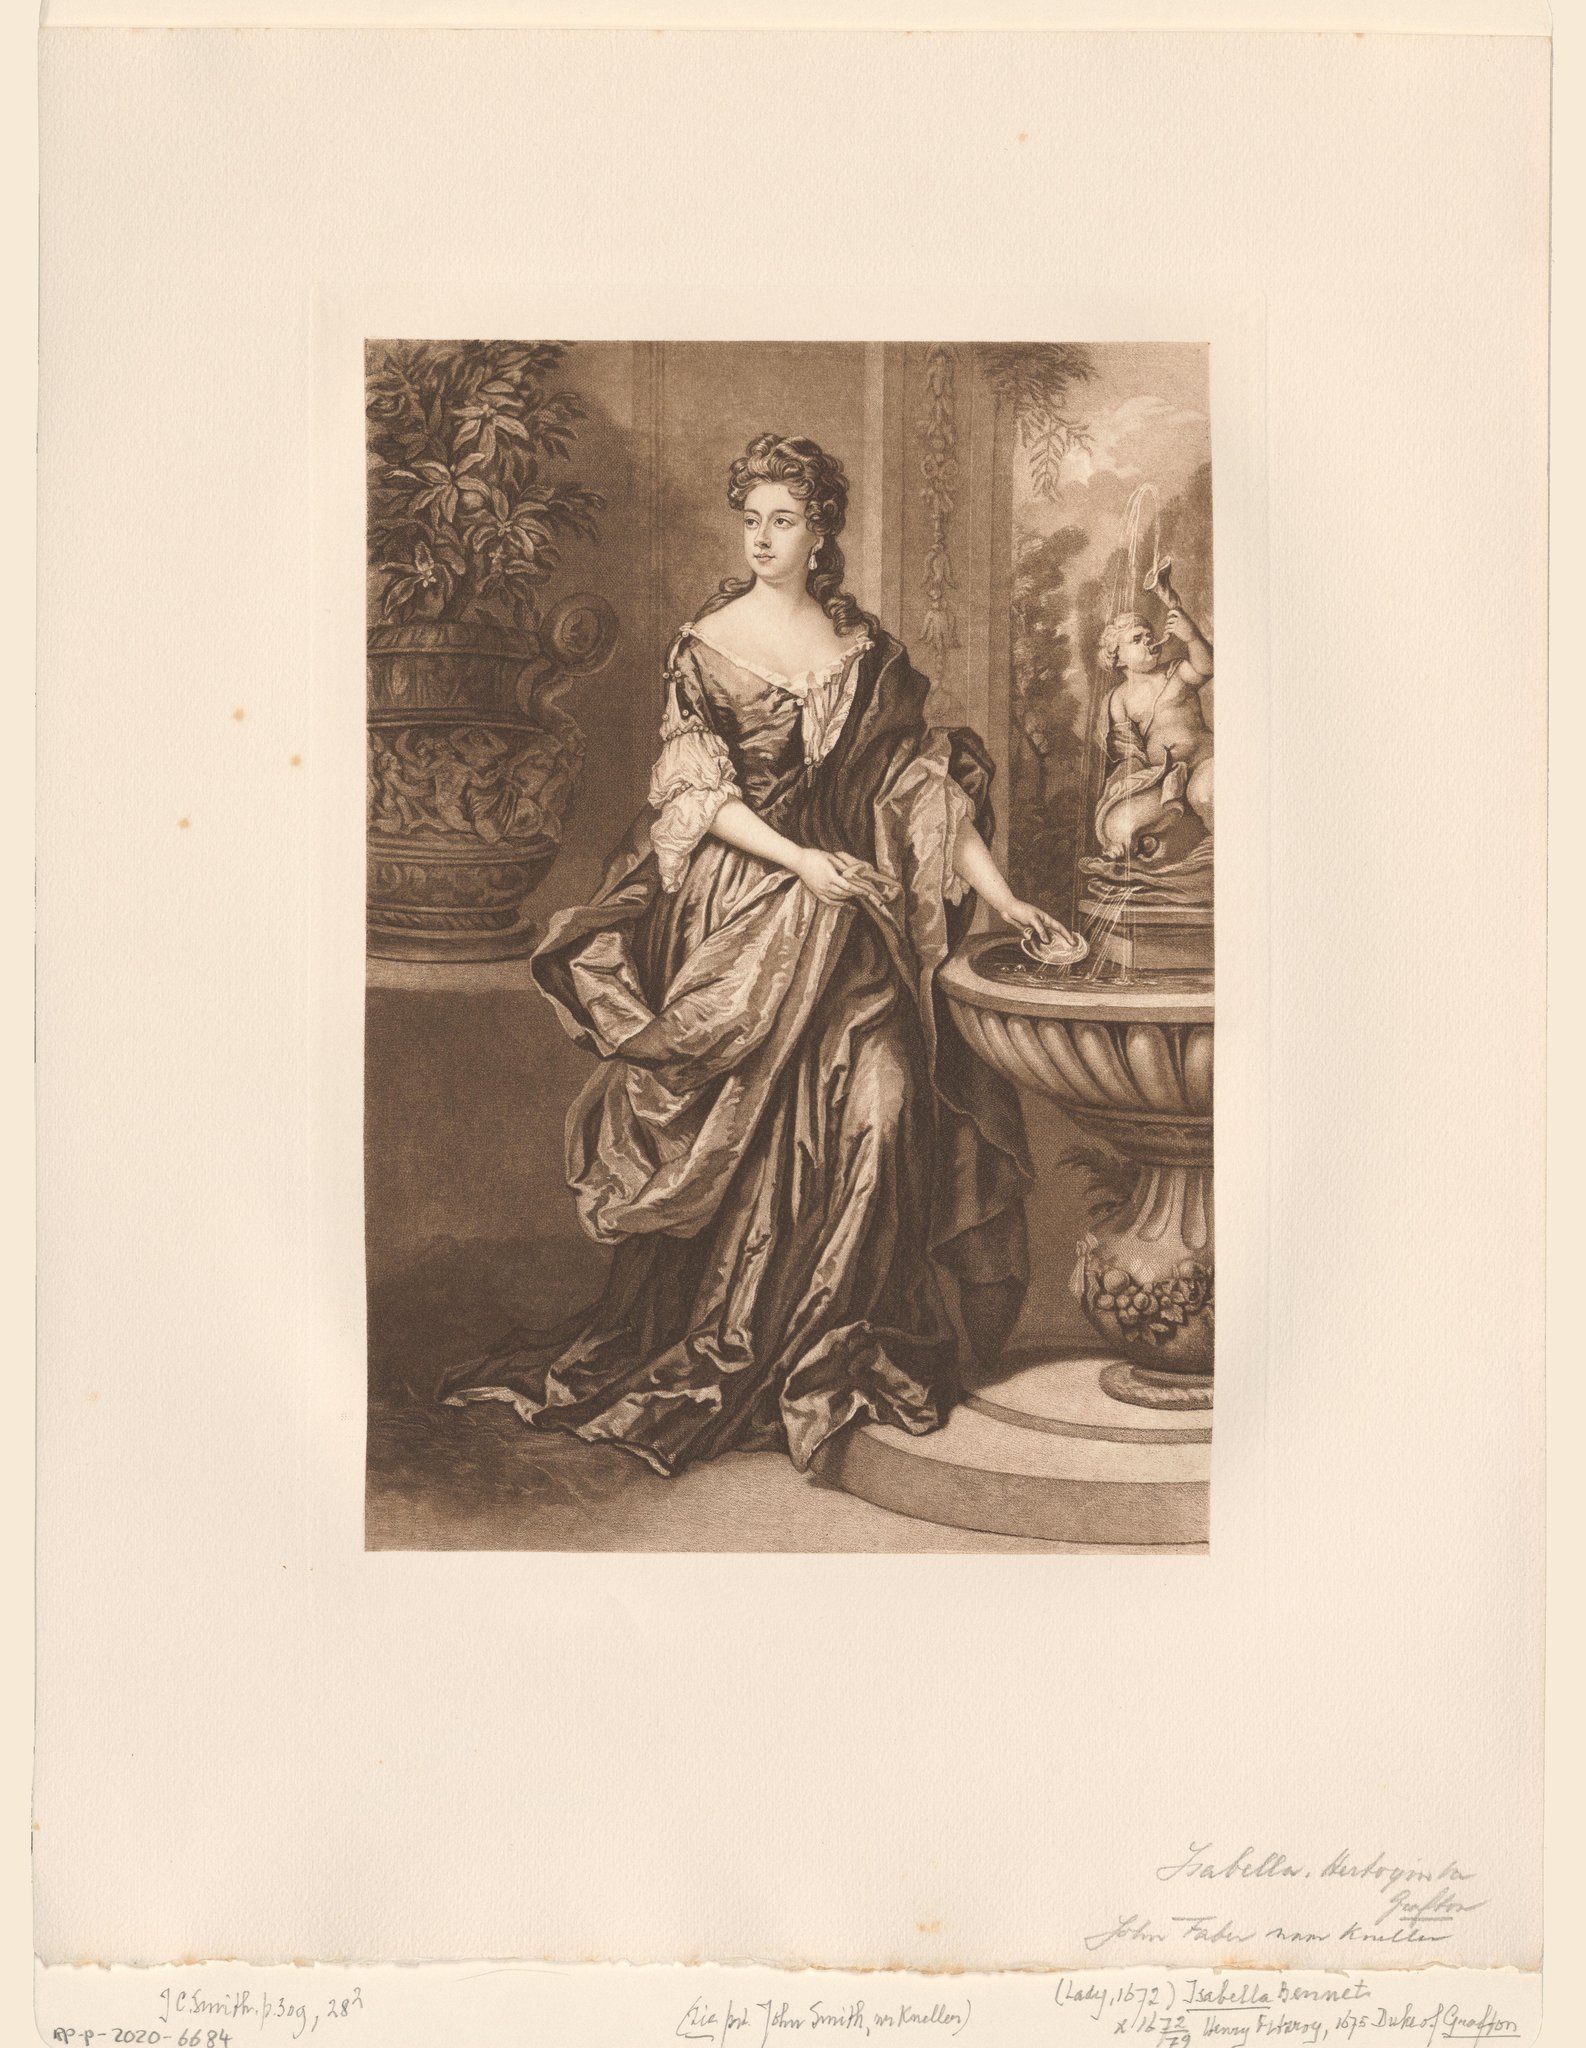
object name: photomechanical print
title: Portret van Isabella Fitzroy, hertogin van Grafton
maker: Anonymous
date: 1850-1930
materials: paper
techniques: photoaquatint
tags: historical persons